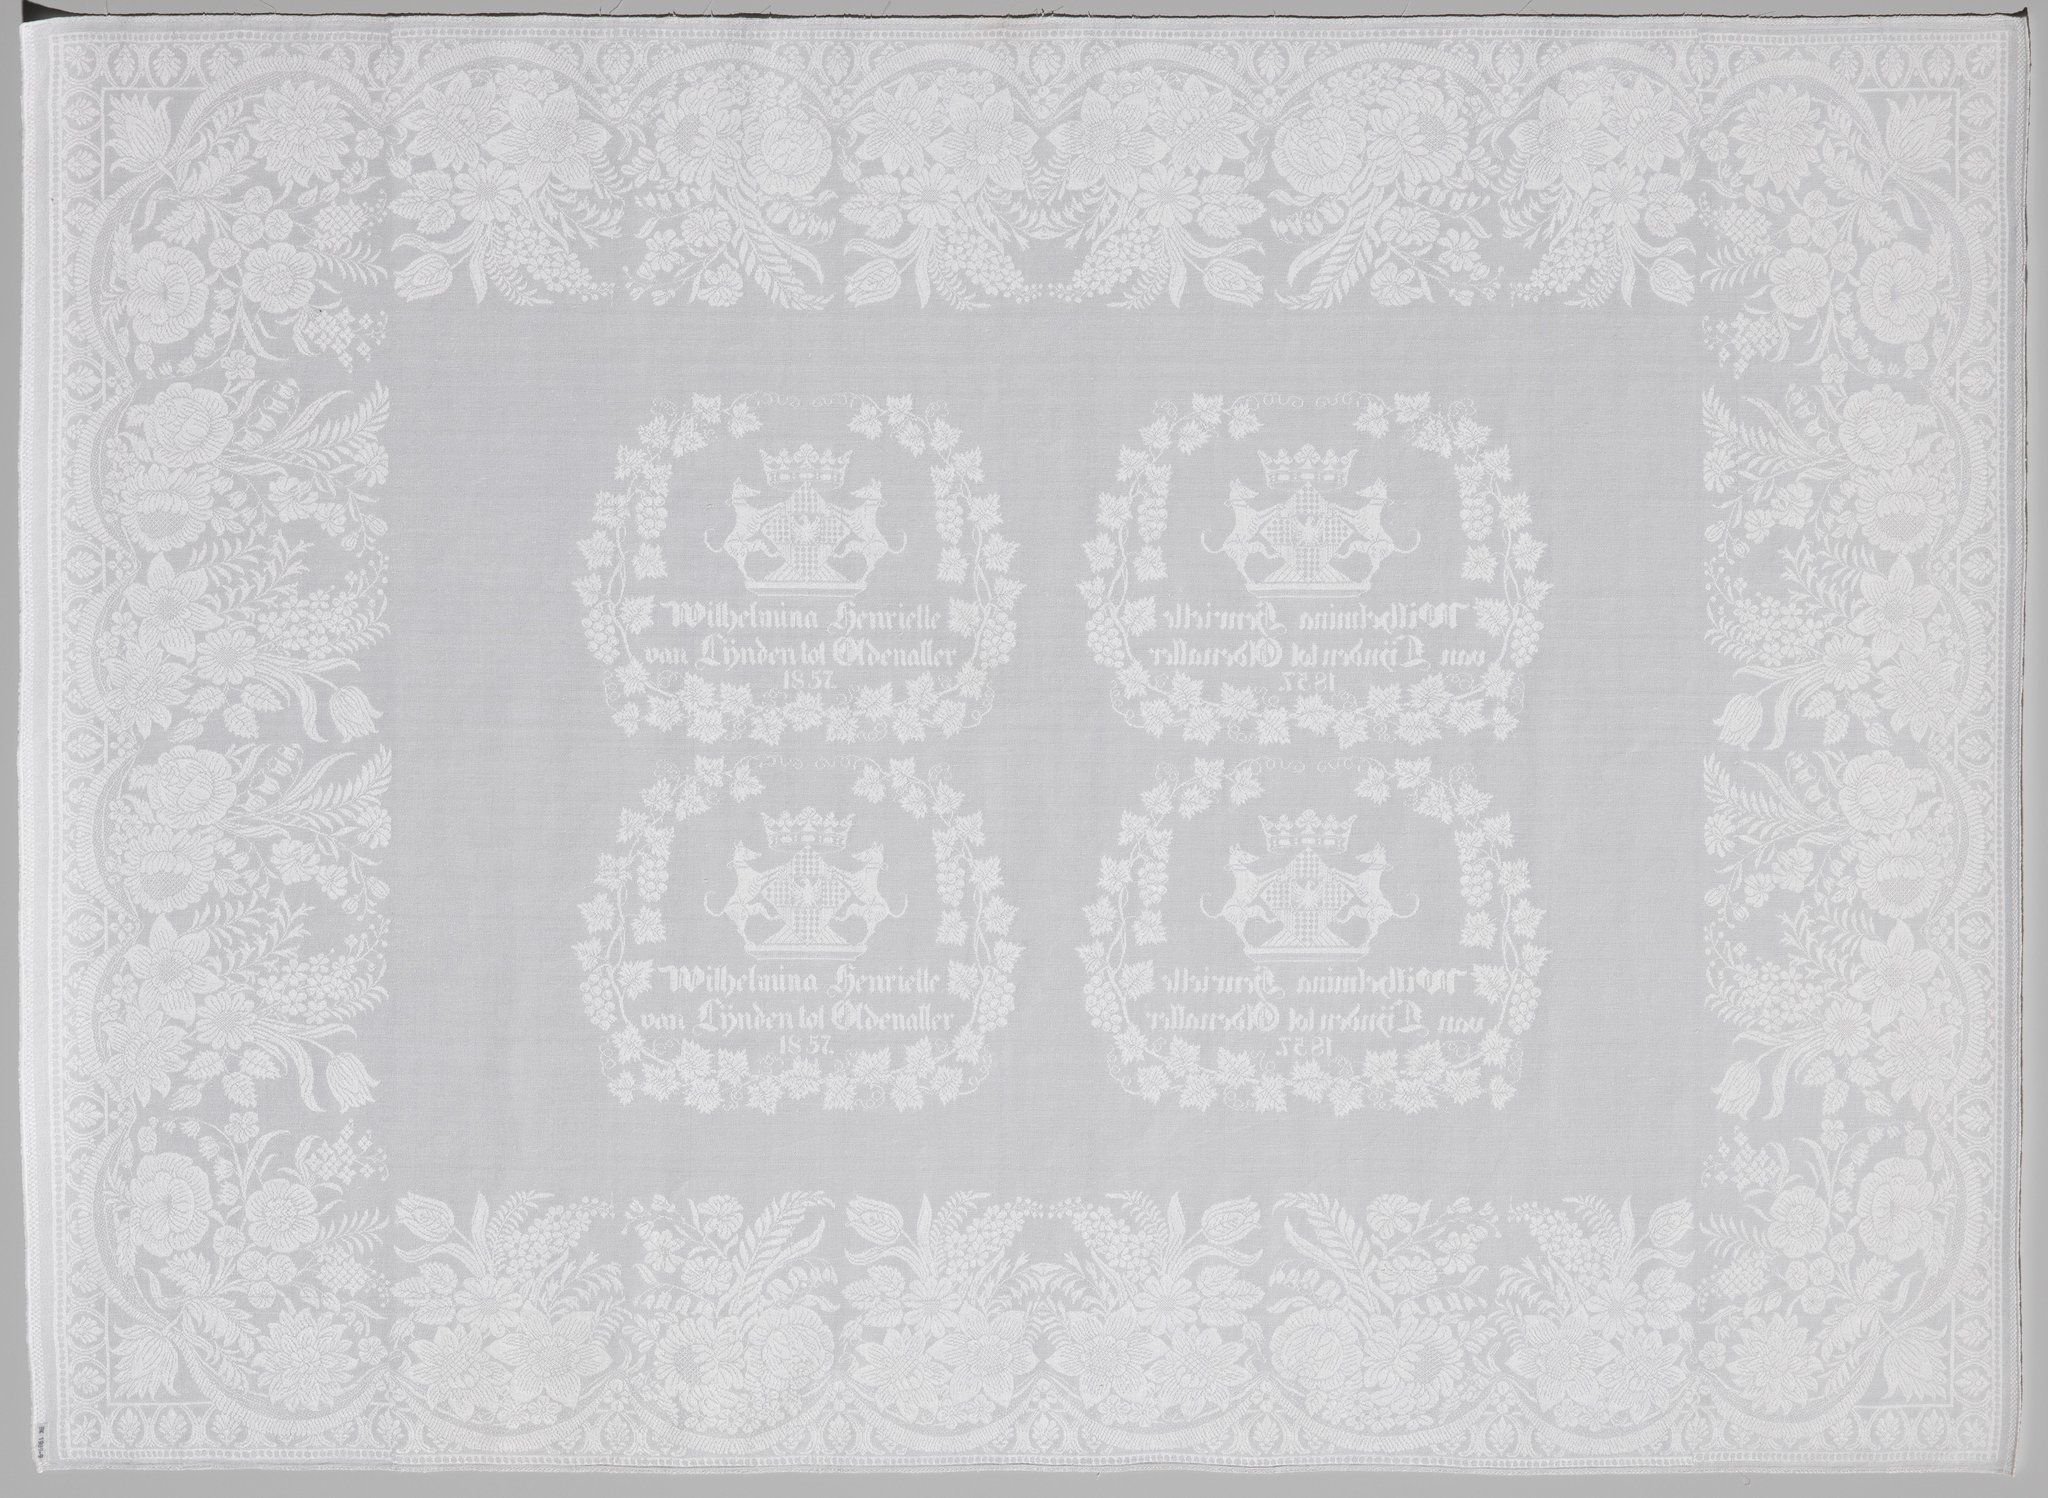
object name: woven material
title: Servet met wapen Wilhelmina Henriette van Lynden tot Oldenaller met jaartal 1857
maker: Anonymous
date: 1857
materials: linen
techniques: damask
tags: nijkerk, jonkvrouw wilhelmina henriette van lynden tot oldenaller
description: Servet van wit linnendamast met vier maal de naam en het wapen van Jkvr. Wilhelmina Henriëtte van Lynden tot Oldenaller en het jaartal 1857 binnen een krans van druivenranken; randen met bloemboeketten, guirlandes en palmetten.